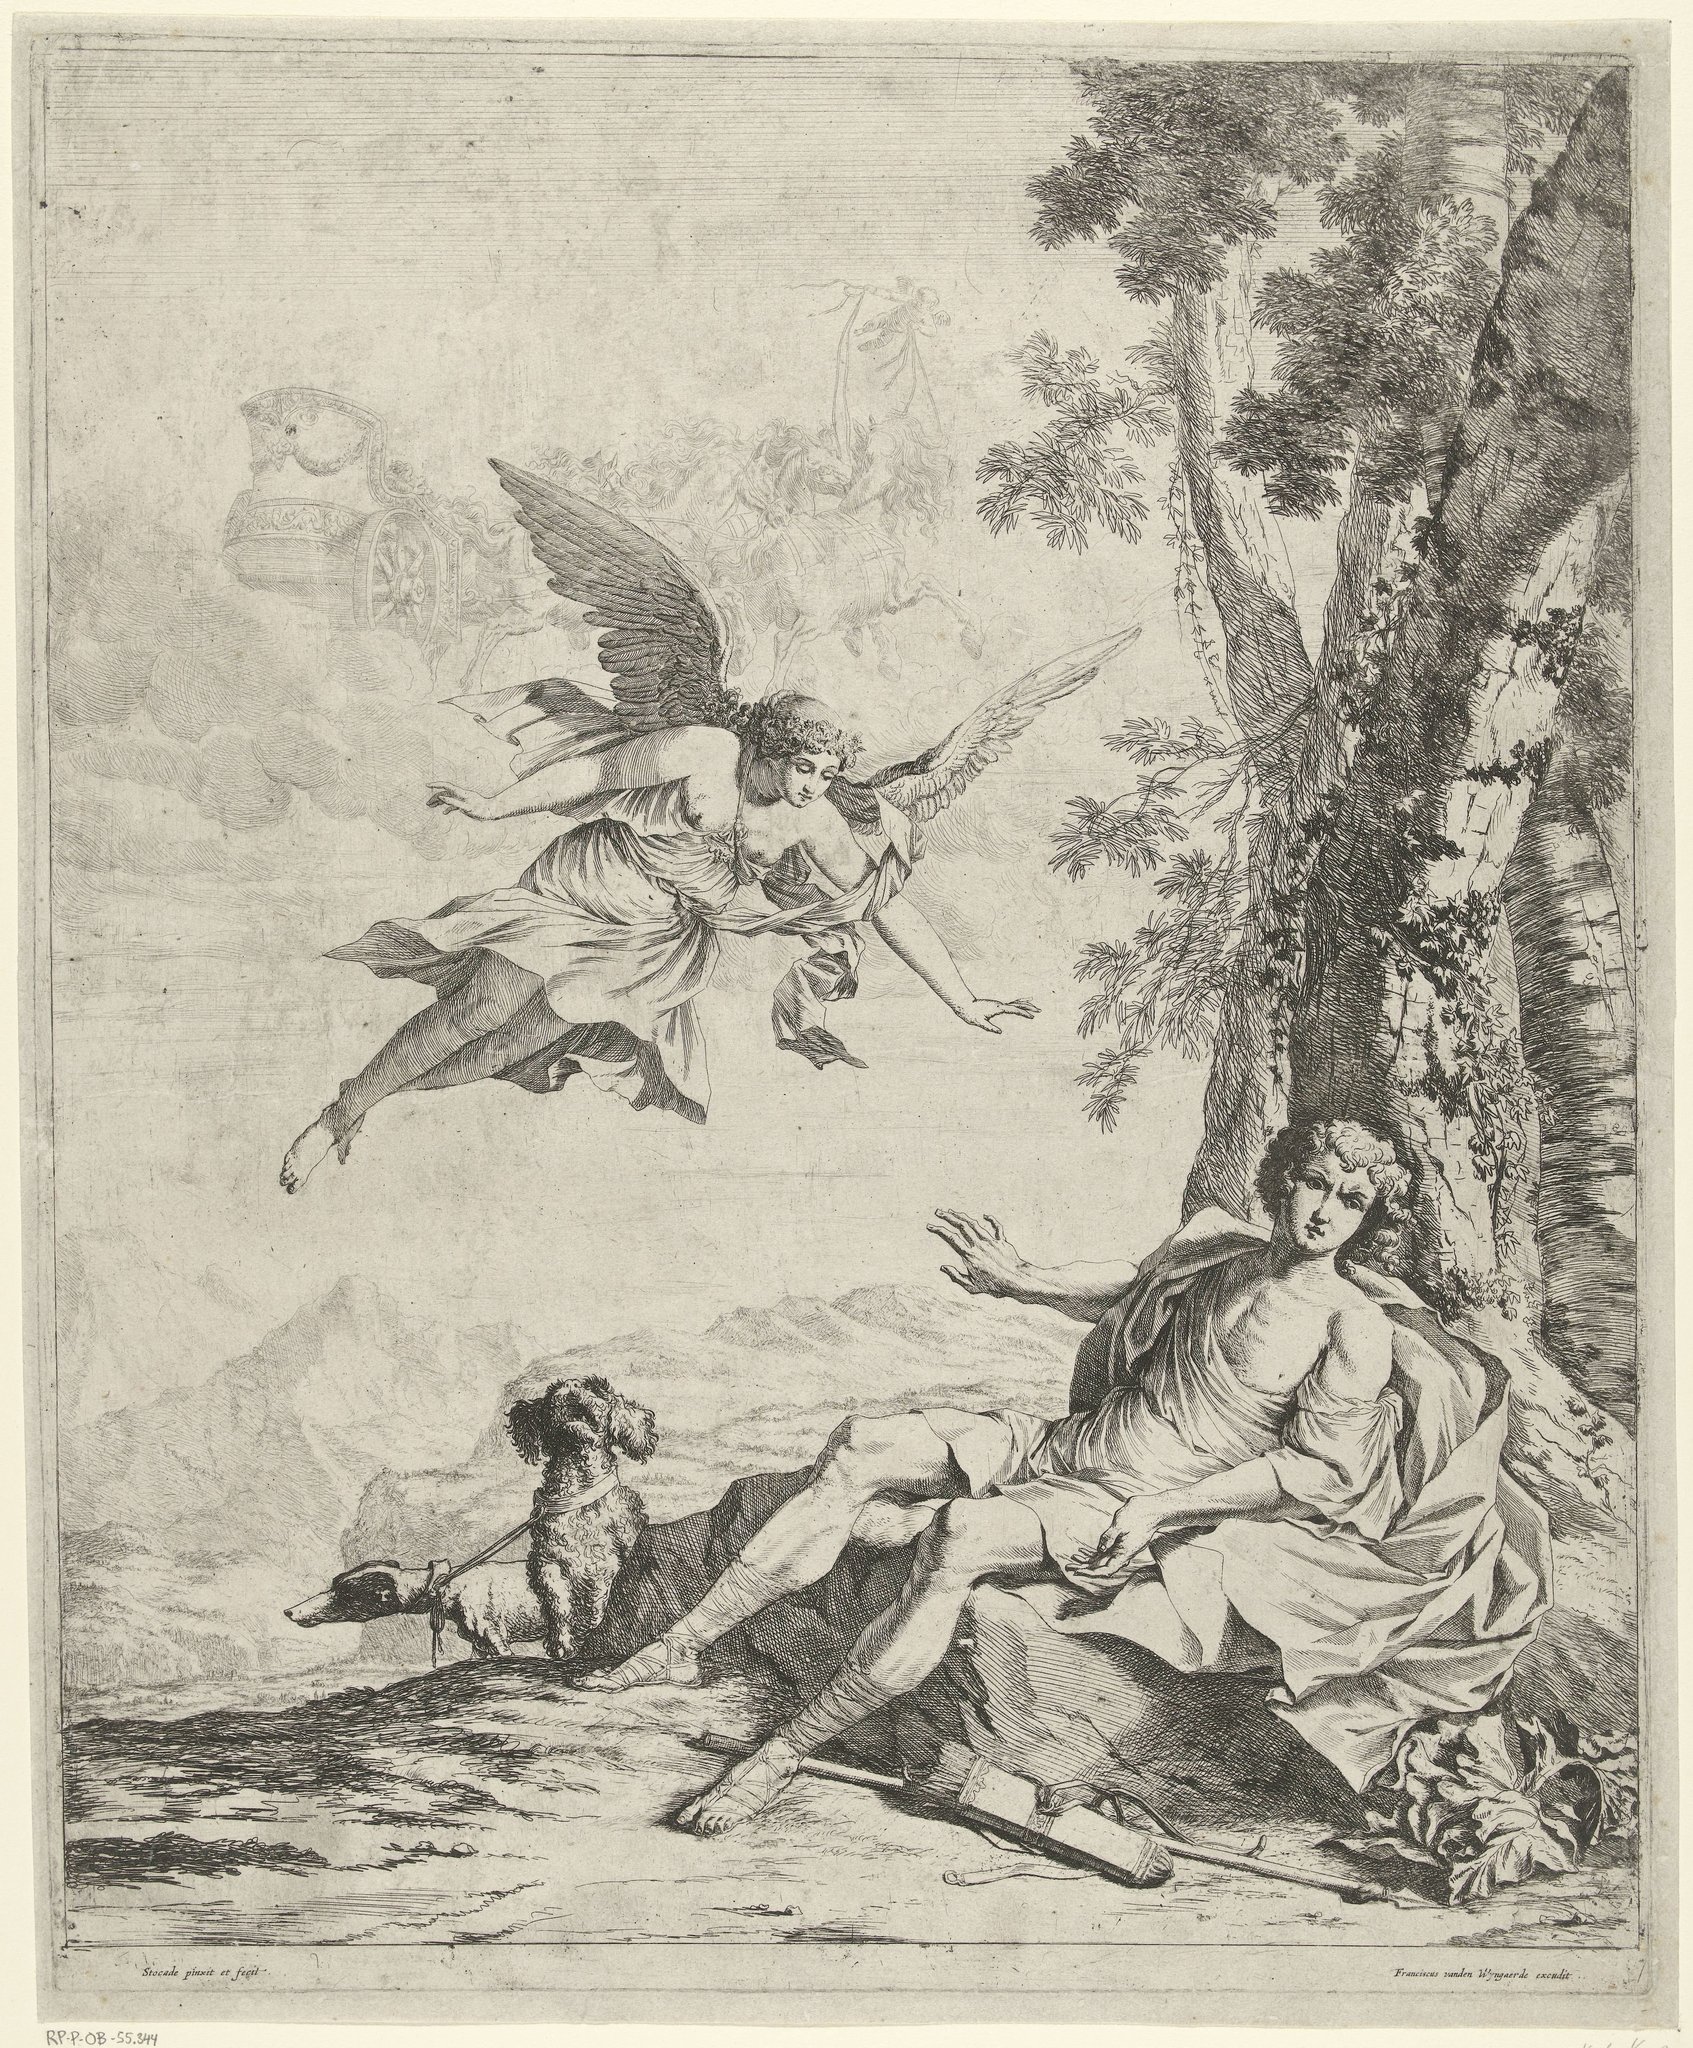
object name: print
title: Roof van Cephalus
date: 1634-1679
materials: paper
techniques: etching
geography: antwerp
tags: dog, quadriga, helved weapons, polearms (for striking, hacking, thrusting): javelin, cephalus and aurora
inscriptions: collector's mark: Lugt 240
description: Een gevleugelde Aurora daalt neer op Cephalus om hem mee te voeren, haar wagen met vier paarden - de quadriga - geleid door een putto staat te wachten in de wolken. Voor Cephalus ligt zijn speer en pijlenkoker, naast hem zijn honden.